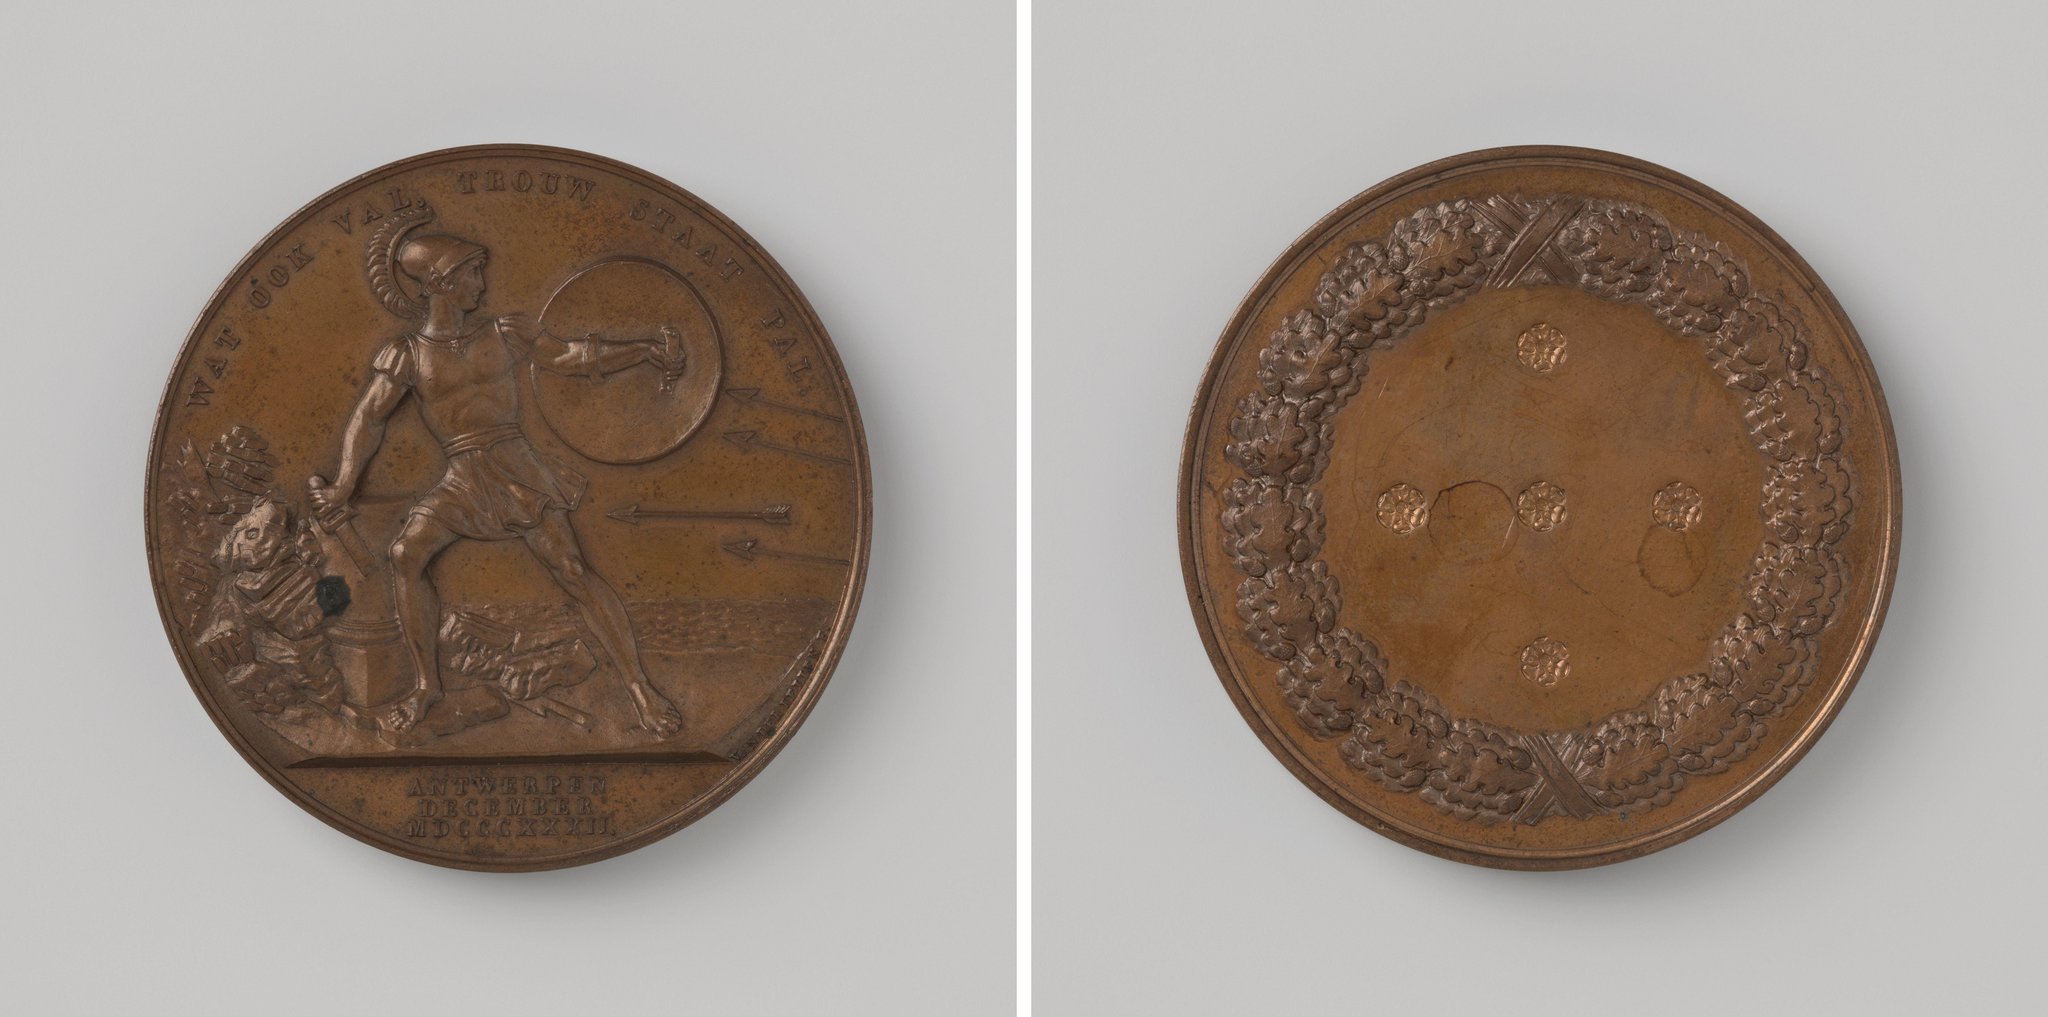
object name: history medal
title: Beloningspenning voor de verdedigers van de Citadel van Antwerpen 1832, met rozetten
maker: david van der kellen (1804-1879)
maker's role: die cutter, draughtsman, print maker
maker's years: 1804-1879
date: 1832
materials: bronze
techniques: printing, striking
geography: utrecht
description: Bronzen penning, op de voorzijde een soldaat, in antieke kleding met schild en gebroken zwaard, naast puinhopen aan een rivier, weert vijandelijke pijlen af, met omschrift en afsnedetekst, op de keerzijde een inscriptieruimte binnen een zware eikenkrans. Ingestempeld vijf rozetten.